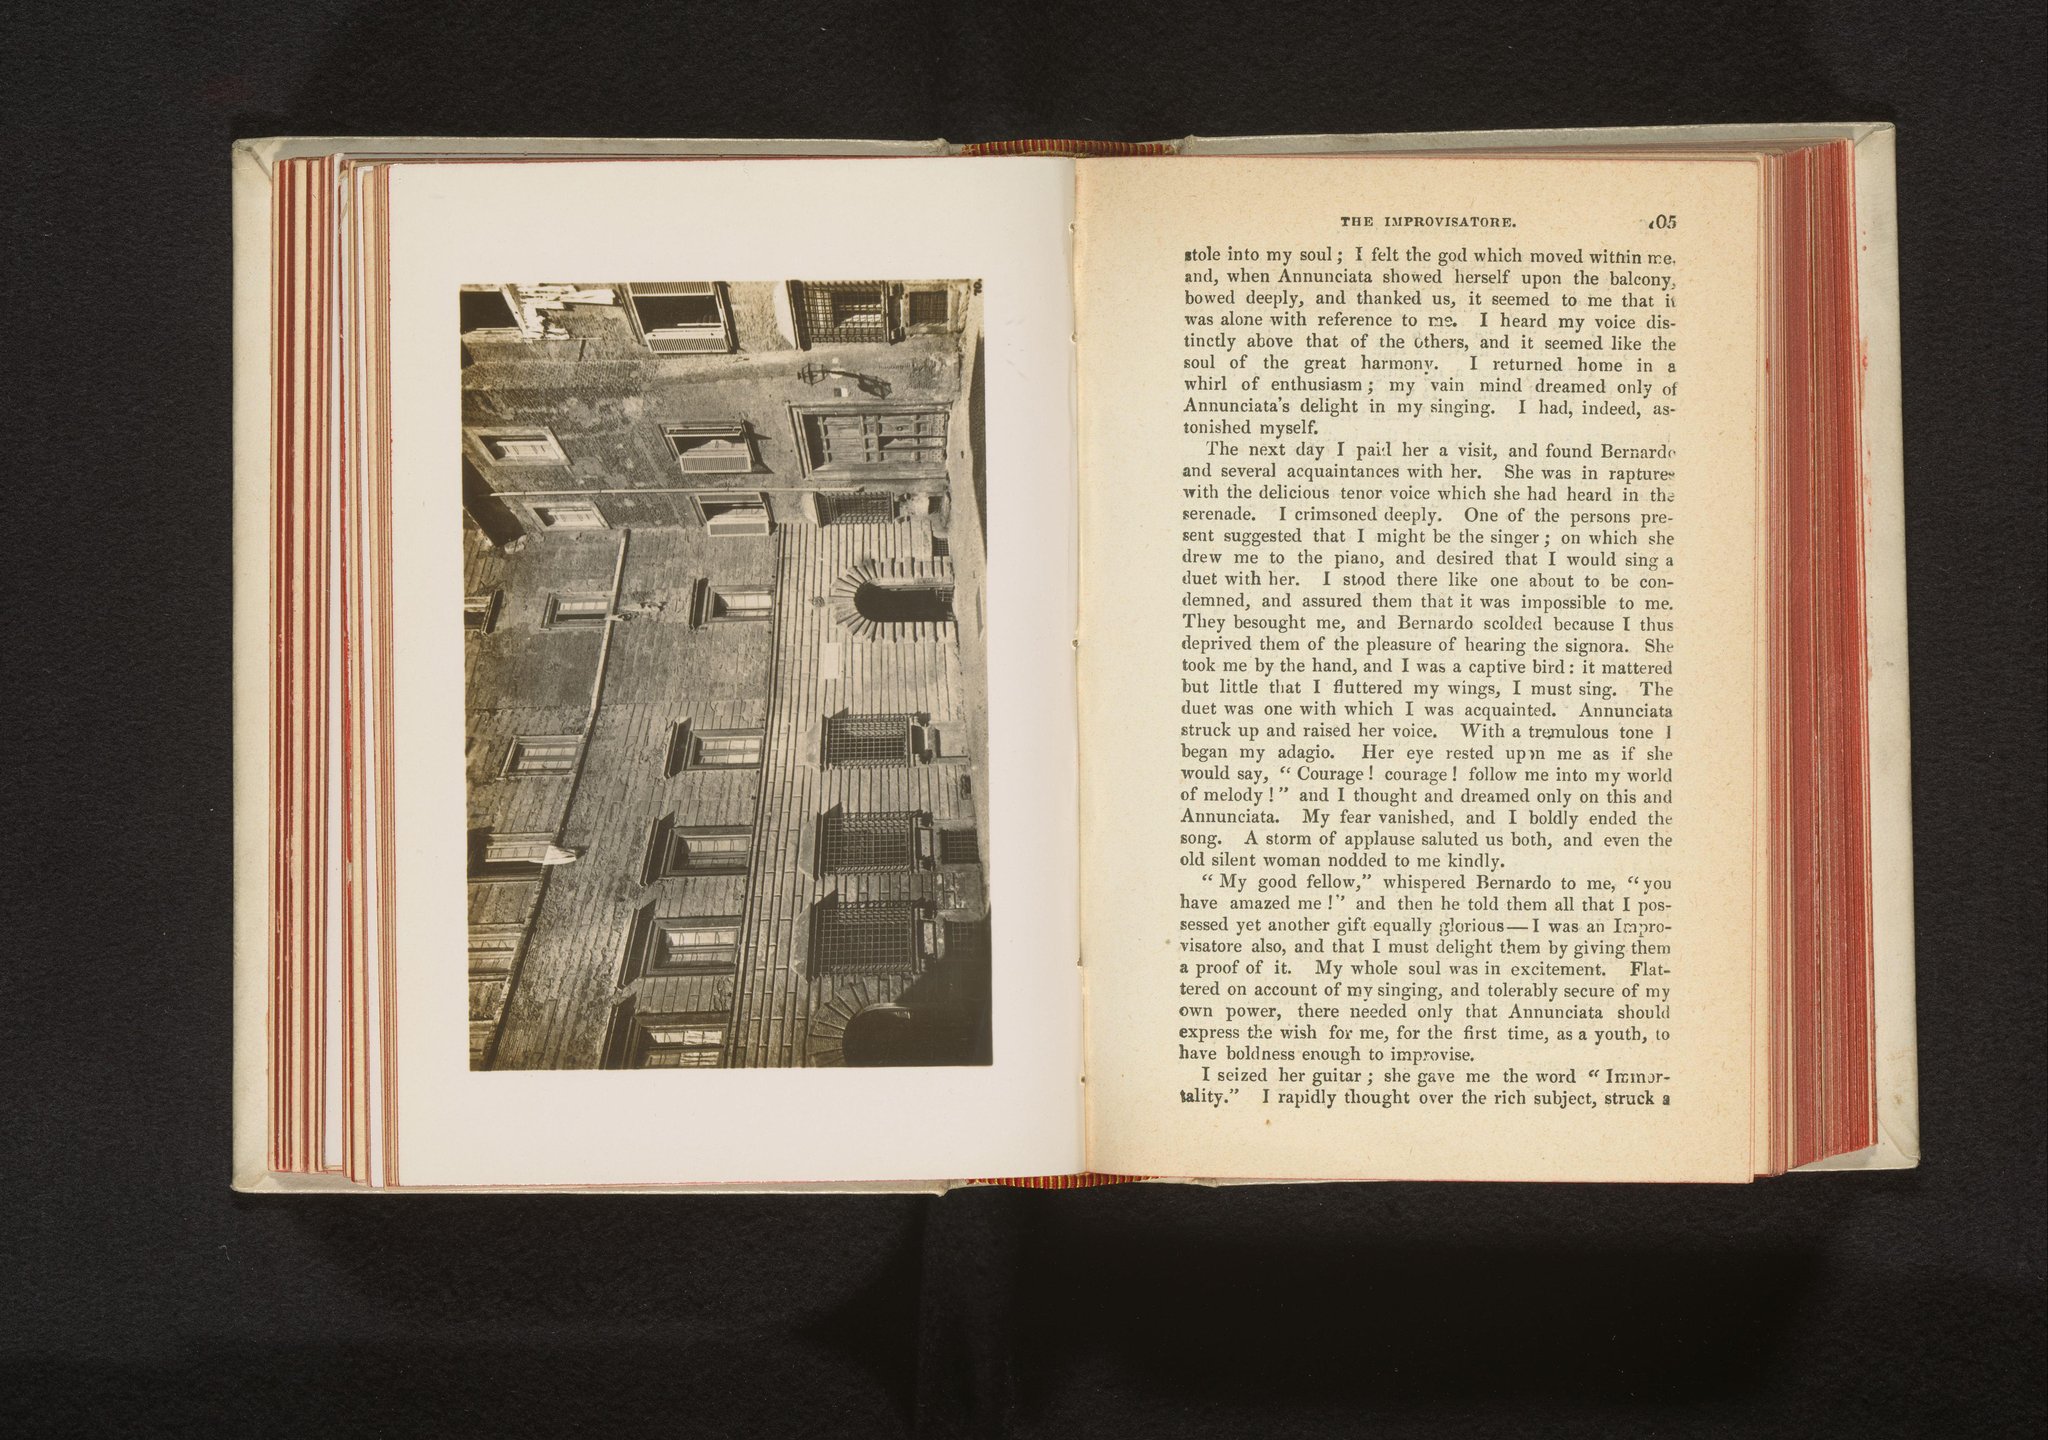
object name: page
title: Gevel van een gebouw te Rome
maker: Anonymous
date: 1870-1880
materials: photographic support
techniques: gelatin silver print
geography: rome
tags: housing, façade (of house or building)